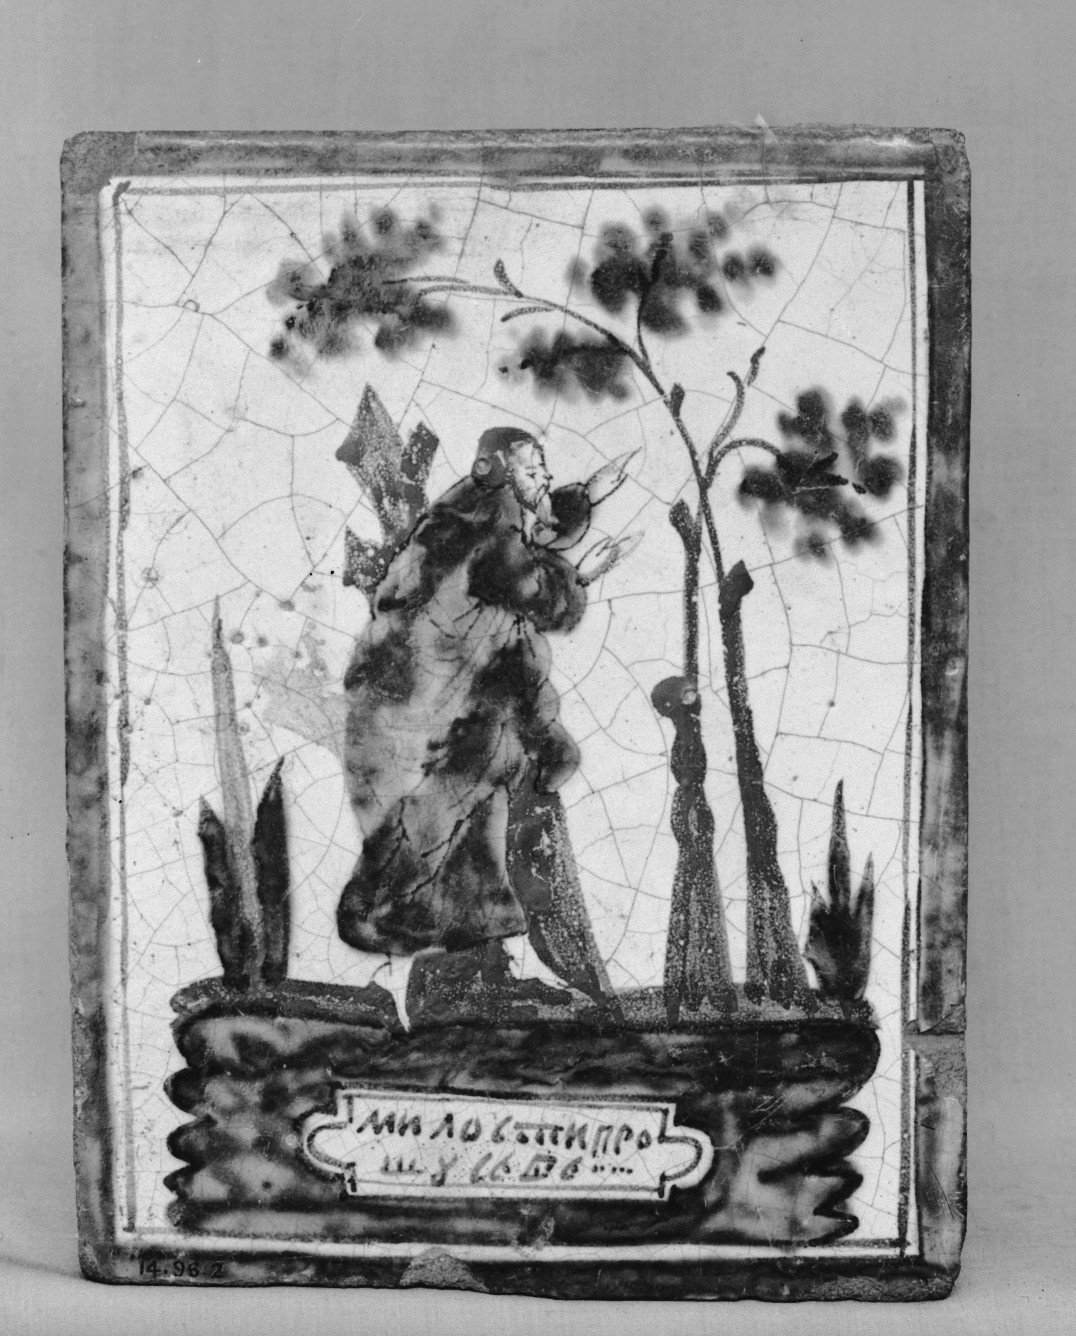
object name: stove tile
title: St. John Preaching in the Wilderness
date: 1701-1800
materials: pottery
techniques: glazing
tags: cyrillic,saint john the baptist